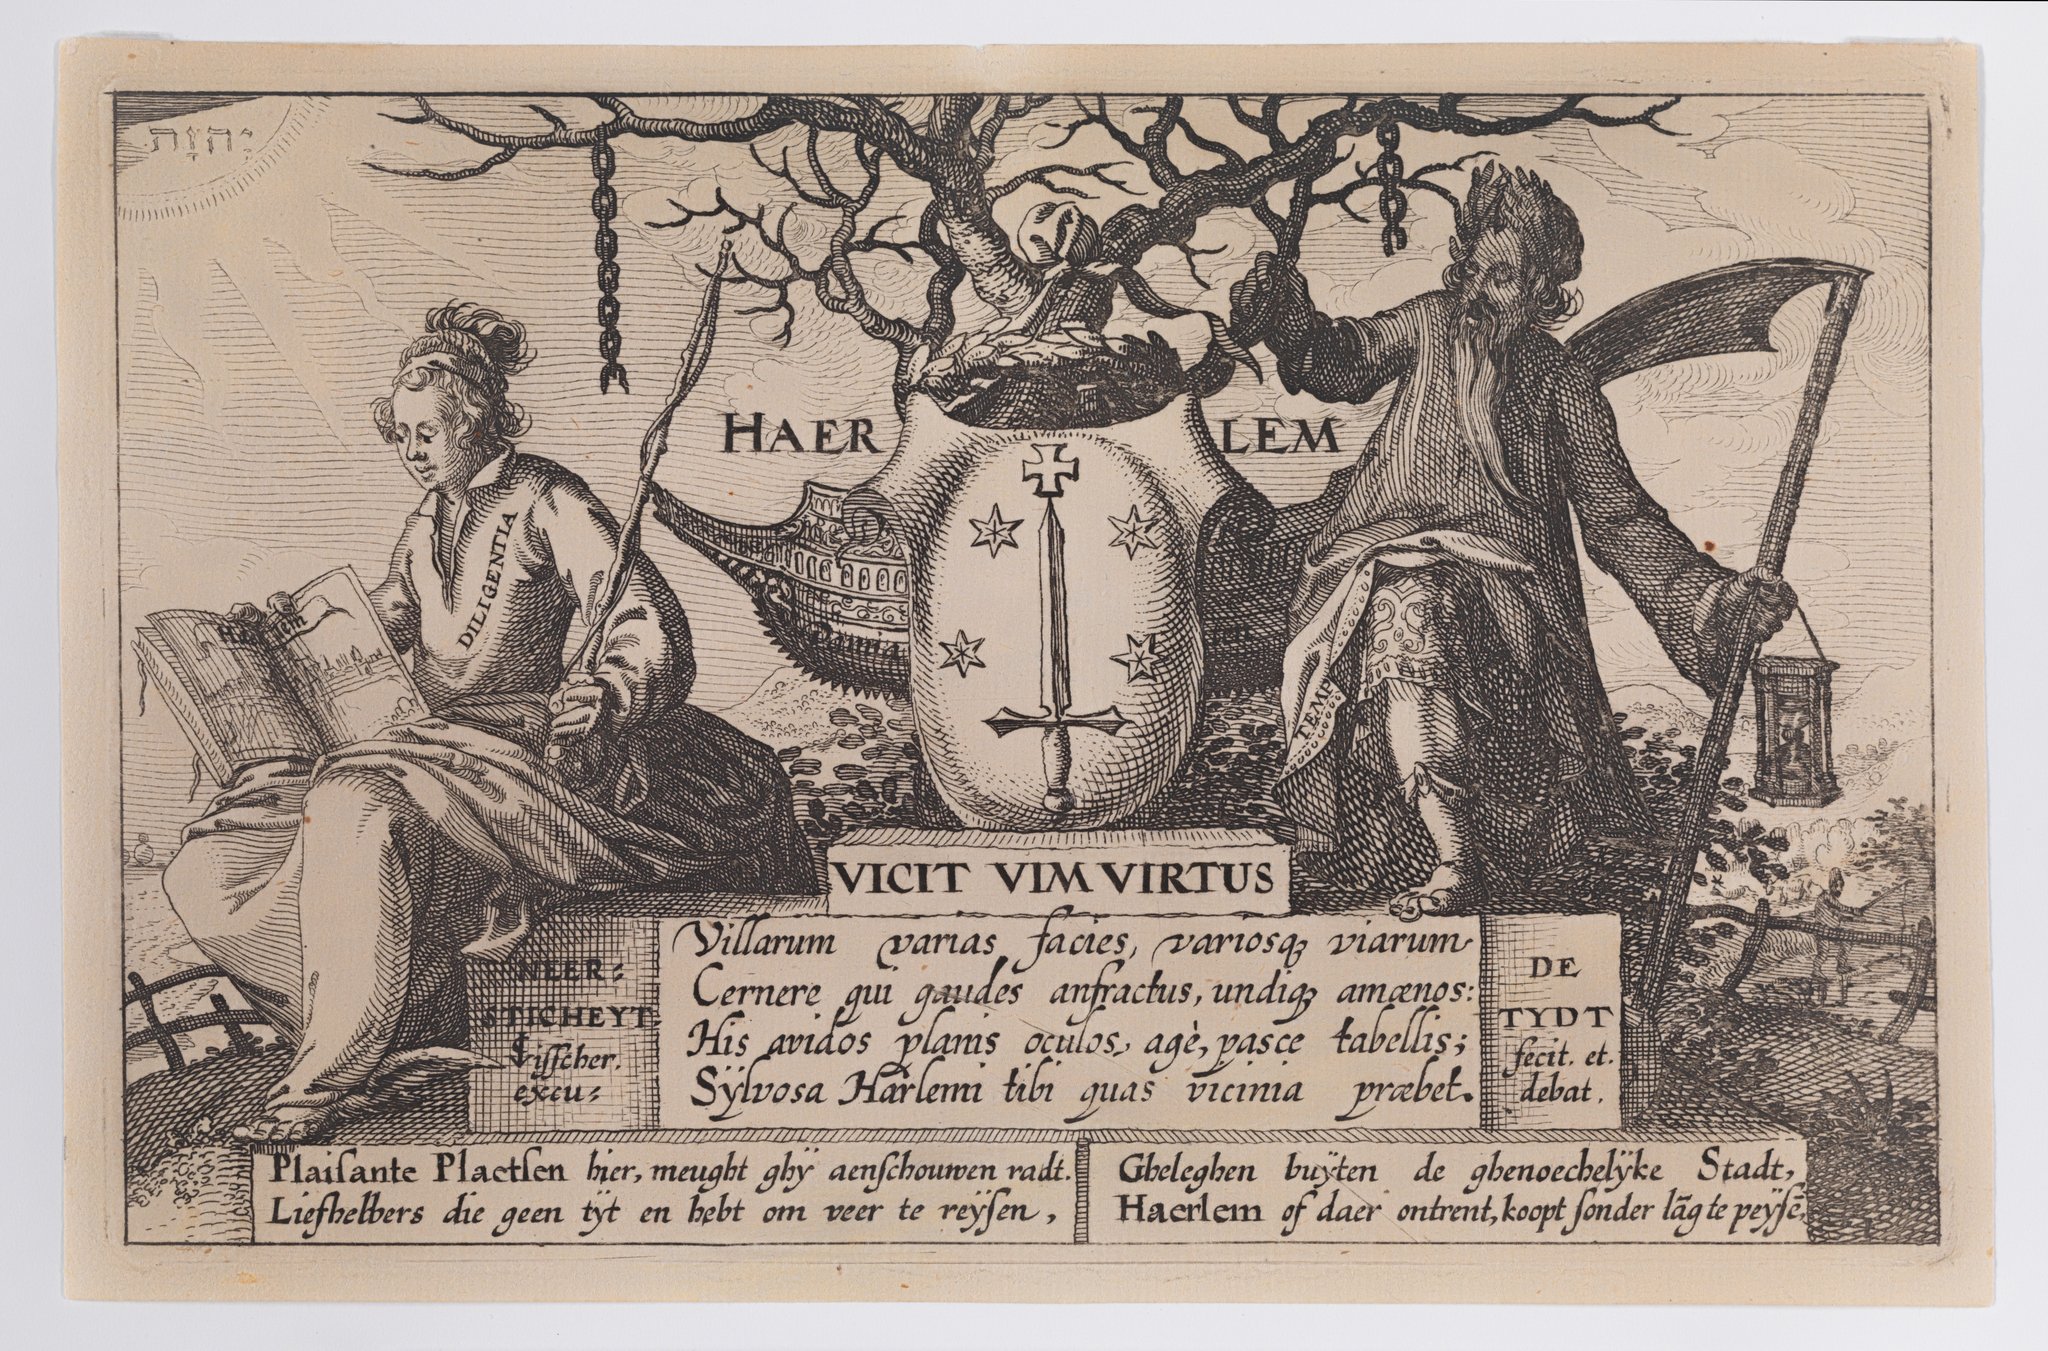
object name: print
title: Views of the Surroundings of Haarlem (Beschryvinge ende lof der stad Haerlem in Holland. In rijm bearbeyd: ende met veele oude ende nieuwe stucken buyten dicht uyt verscheyde kroniken, handvesten, brieven, memorien ofte geheugenissen ende diergelijke schriften verklaerd ende bevestigd)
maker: claes jansz. visscher (ii)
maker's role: artist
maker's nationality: dutch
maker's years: 1586-1652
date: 1628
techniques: engraving, etching